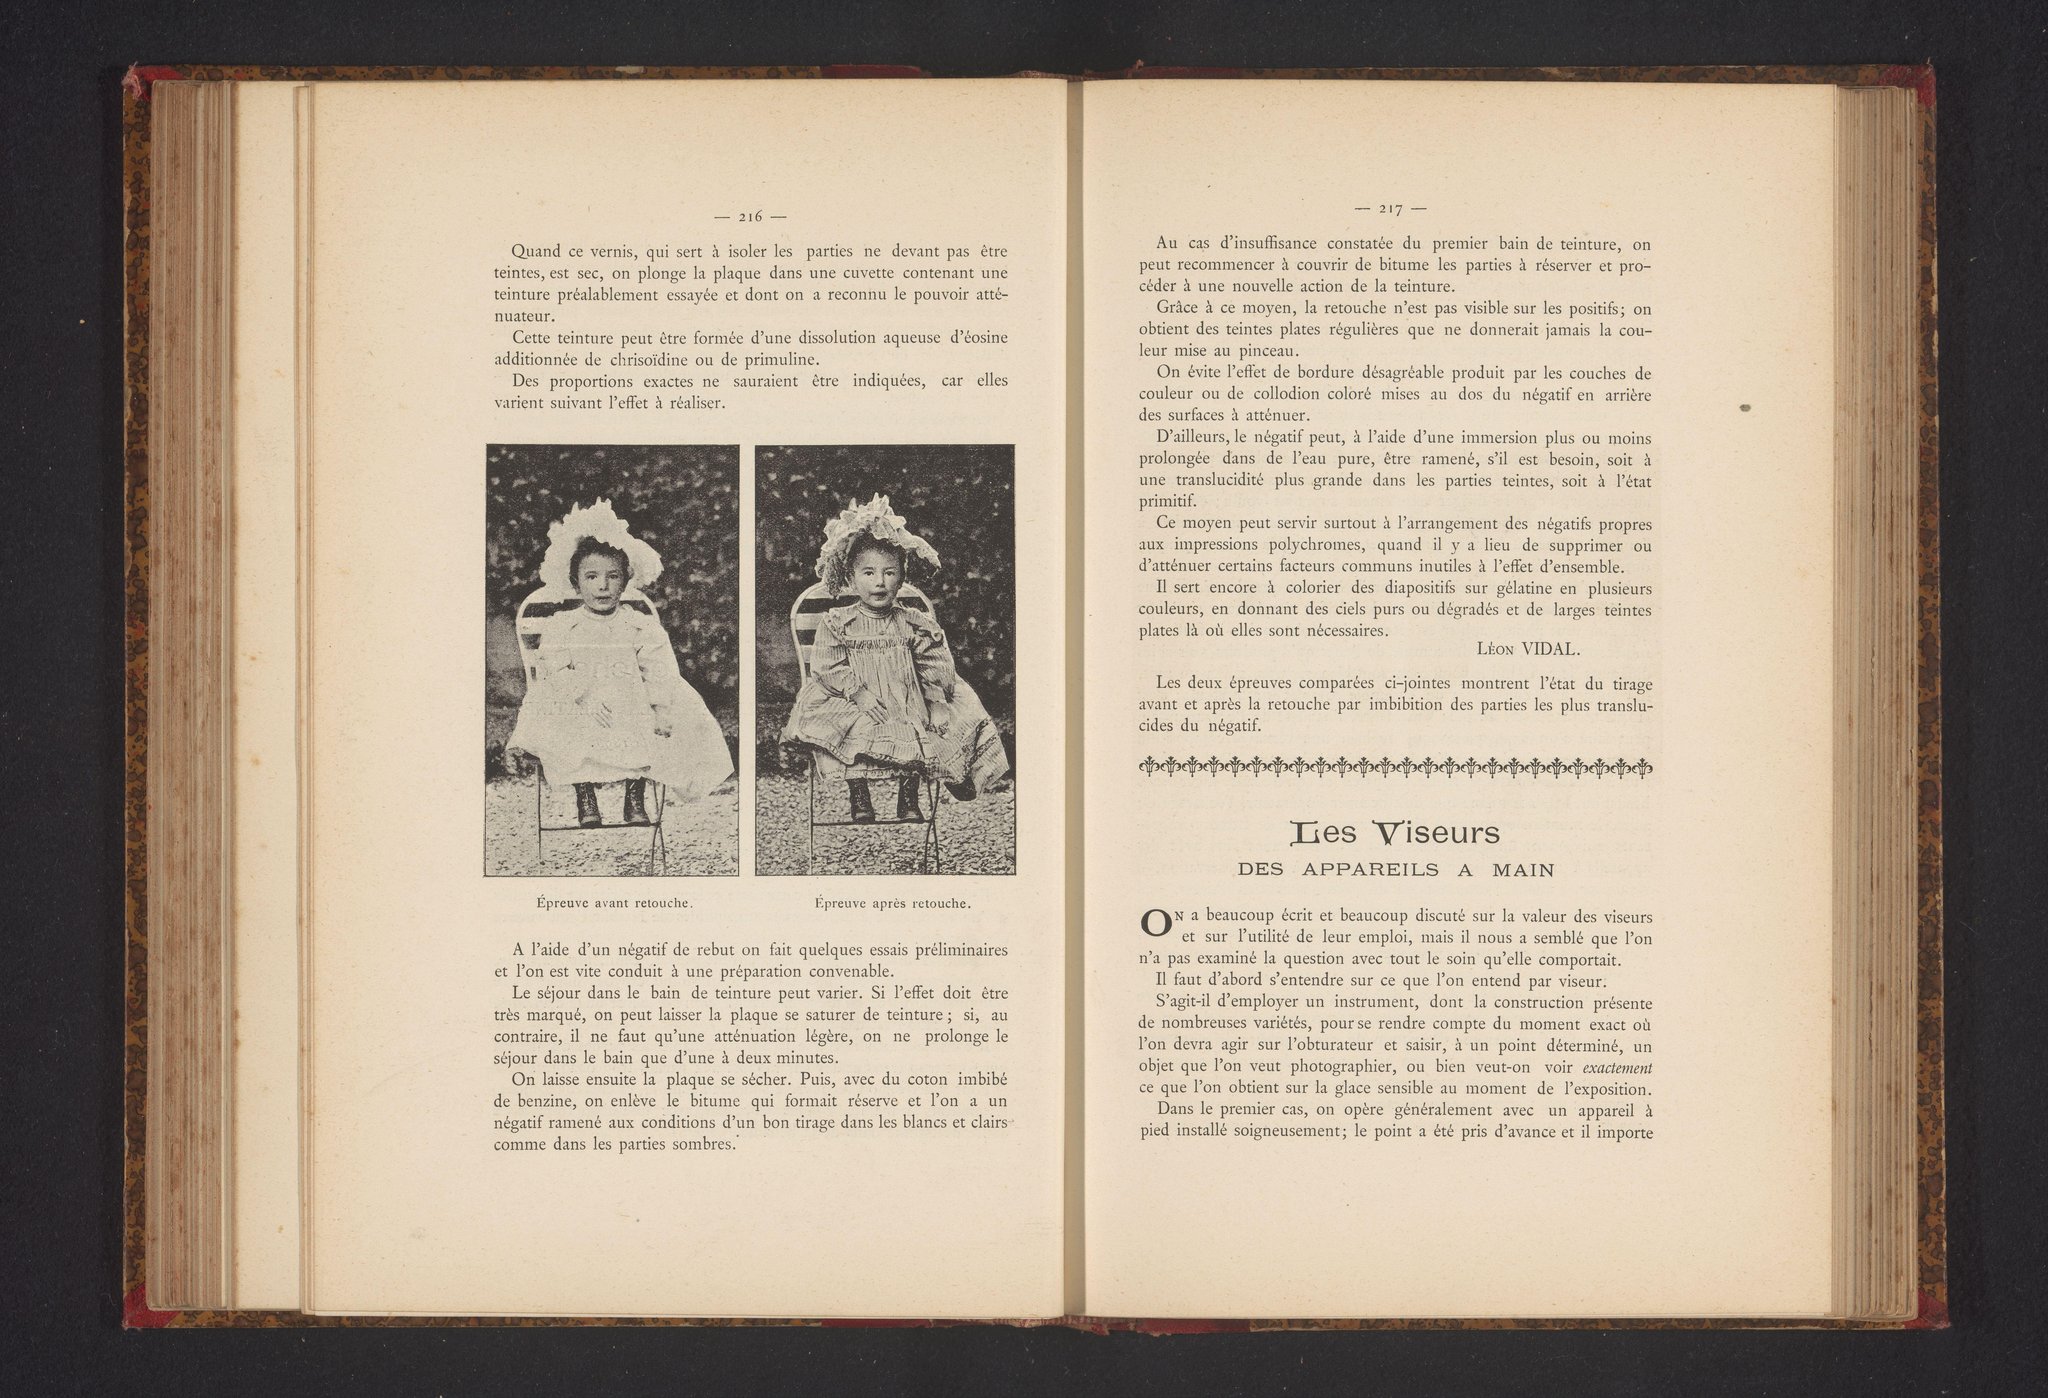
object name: page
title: Épreuve après retouche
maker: Anonymous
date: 1888-1893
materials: paper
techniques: autotype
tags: historical persons not known by name - bb - woman, toddler (female), chair